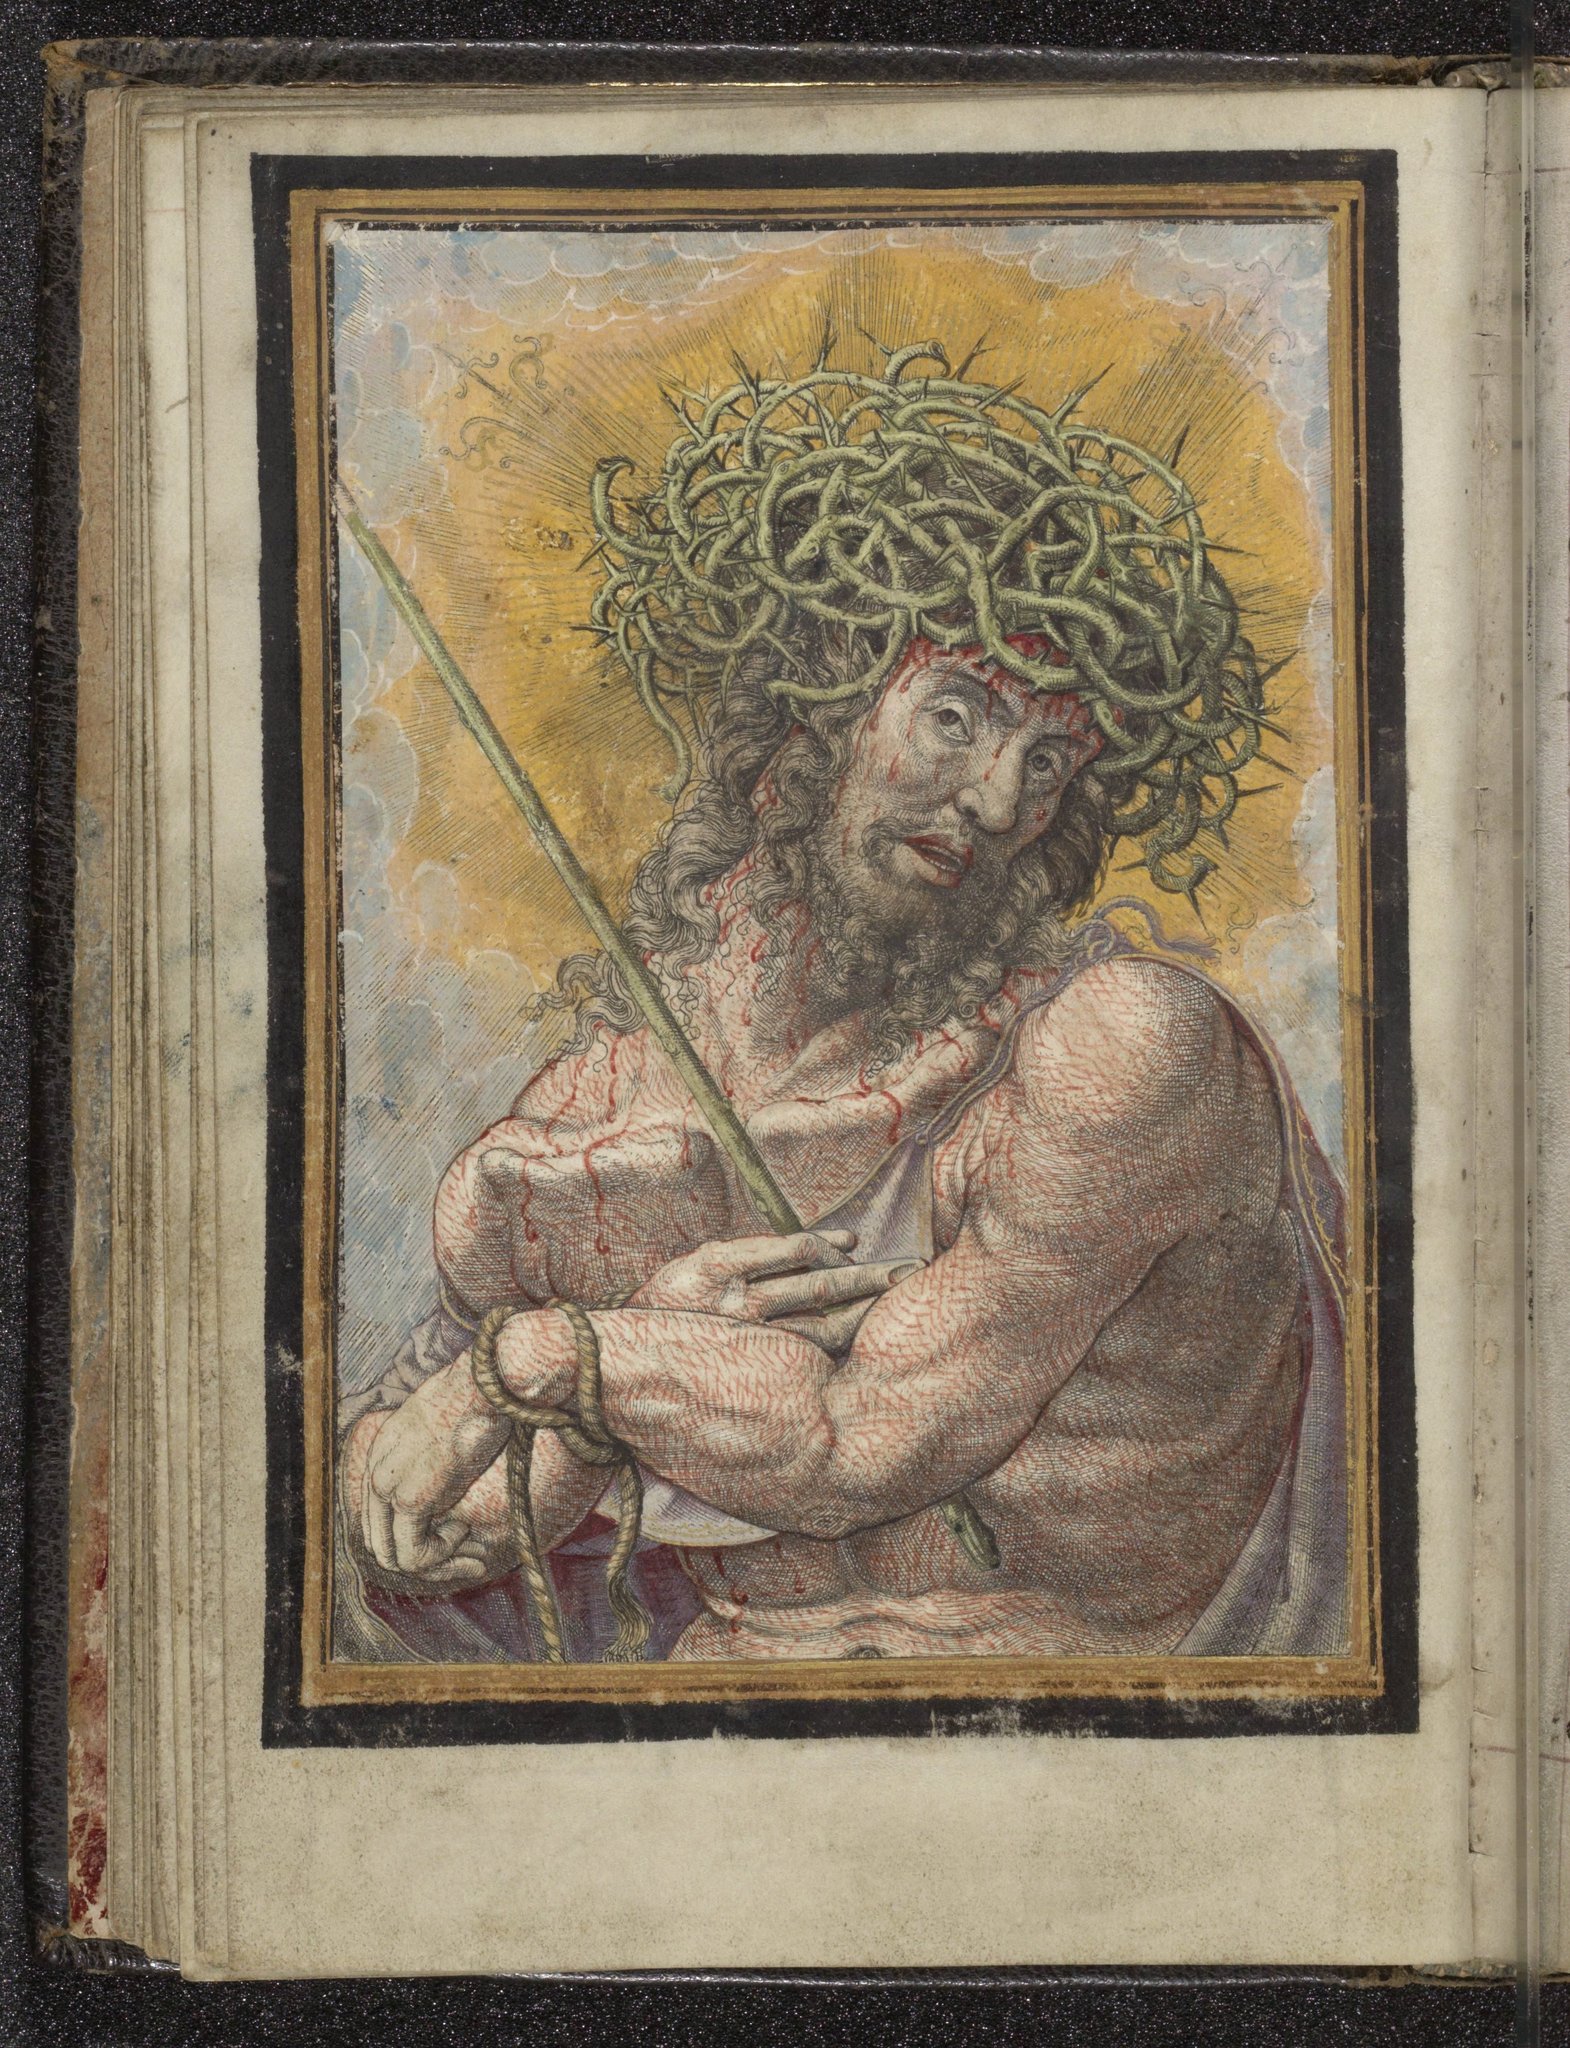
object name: print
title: Christ as the Man of Sorrows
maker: frans crabbe van espleghem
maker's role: print maker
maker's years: 1480-1552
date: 1497-1552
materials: paper, parchment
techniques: engraving, hand coloring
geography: mechelen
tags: half or three-quarter figure of the man of sorrows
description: Eighteen hand-coloured engravings are pasted onto the parchment pages in this book of hours. The combination of handwriting and coloured-in prints illustrates the gradual transition from the handwritten to the printed world. Christ’s suffering comes across more powerfully through the blood, applied in red wash with a fine brush, covering his entire body.